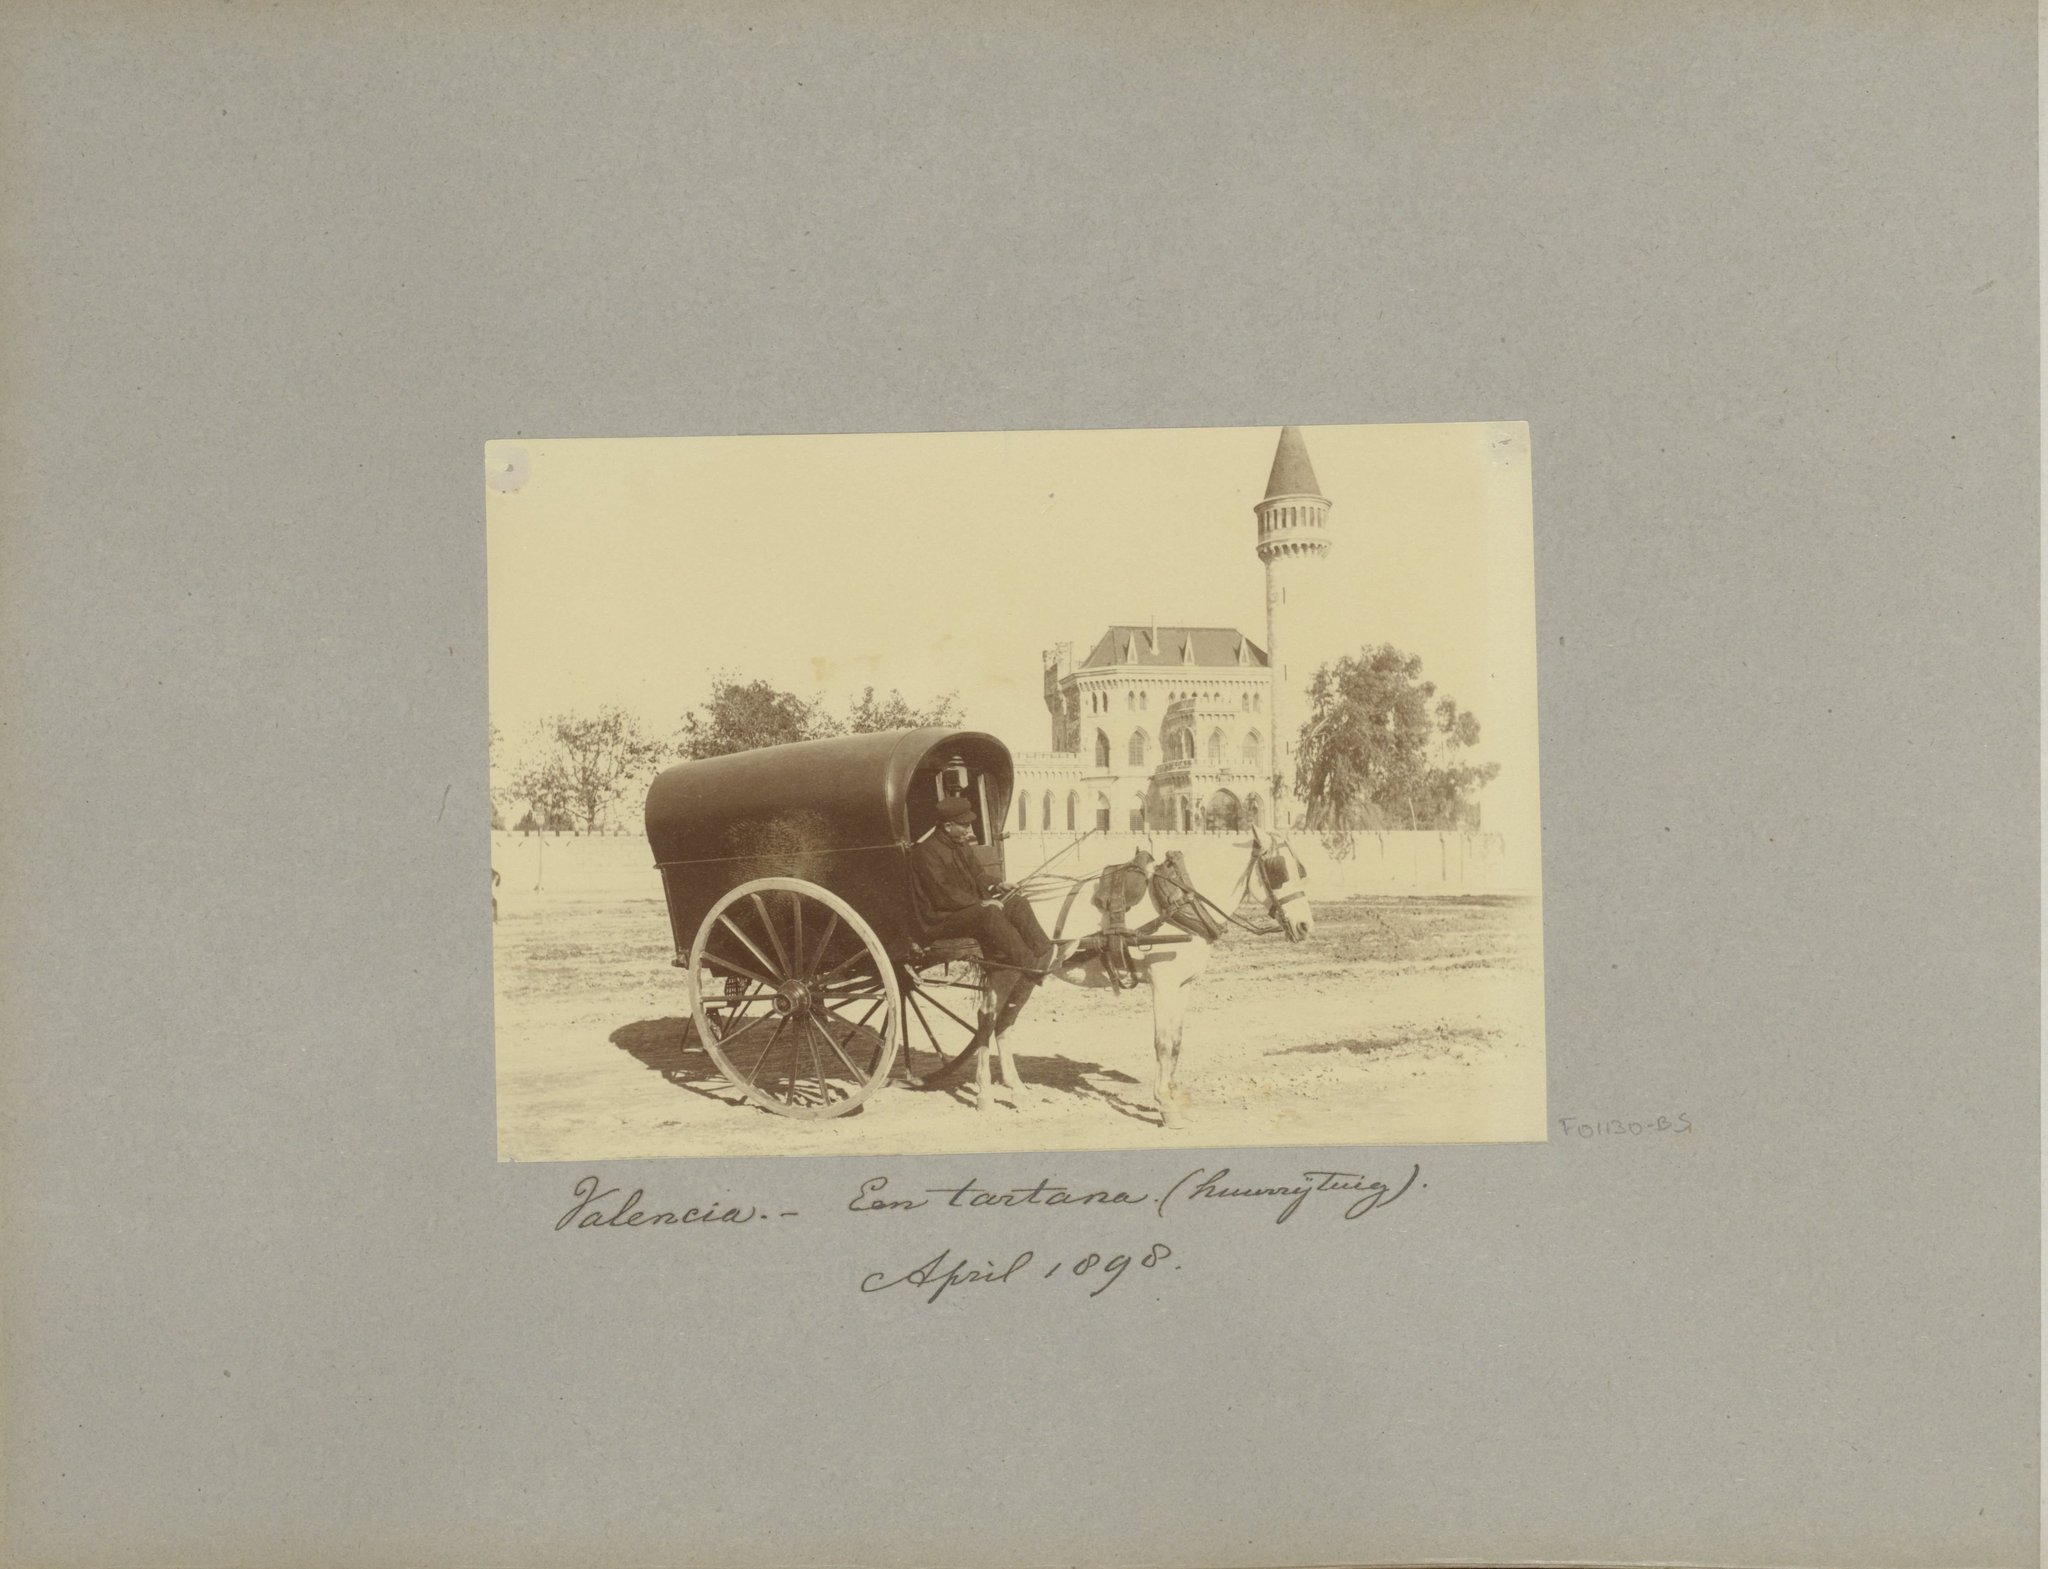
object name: album leaf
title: Wachtend huurrijtuig (tartana) voor Palacio de Ripalda in Valencia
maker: Anonymous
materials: paper, photographic support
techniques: albumen print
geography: valencia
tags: castle, two-wheeled, animal-drawn vehicle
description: Onderdeel van Reisalbum met foto's van bezienswaardigheden in Frankrijk, Spanje, Italië, Duitsland, Zwitserland en Oostenrijk.